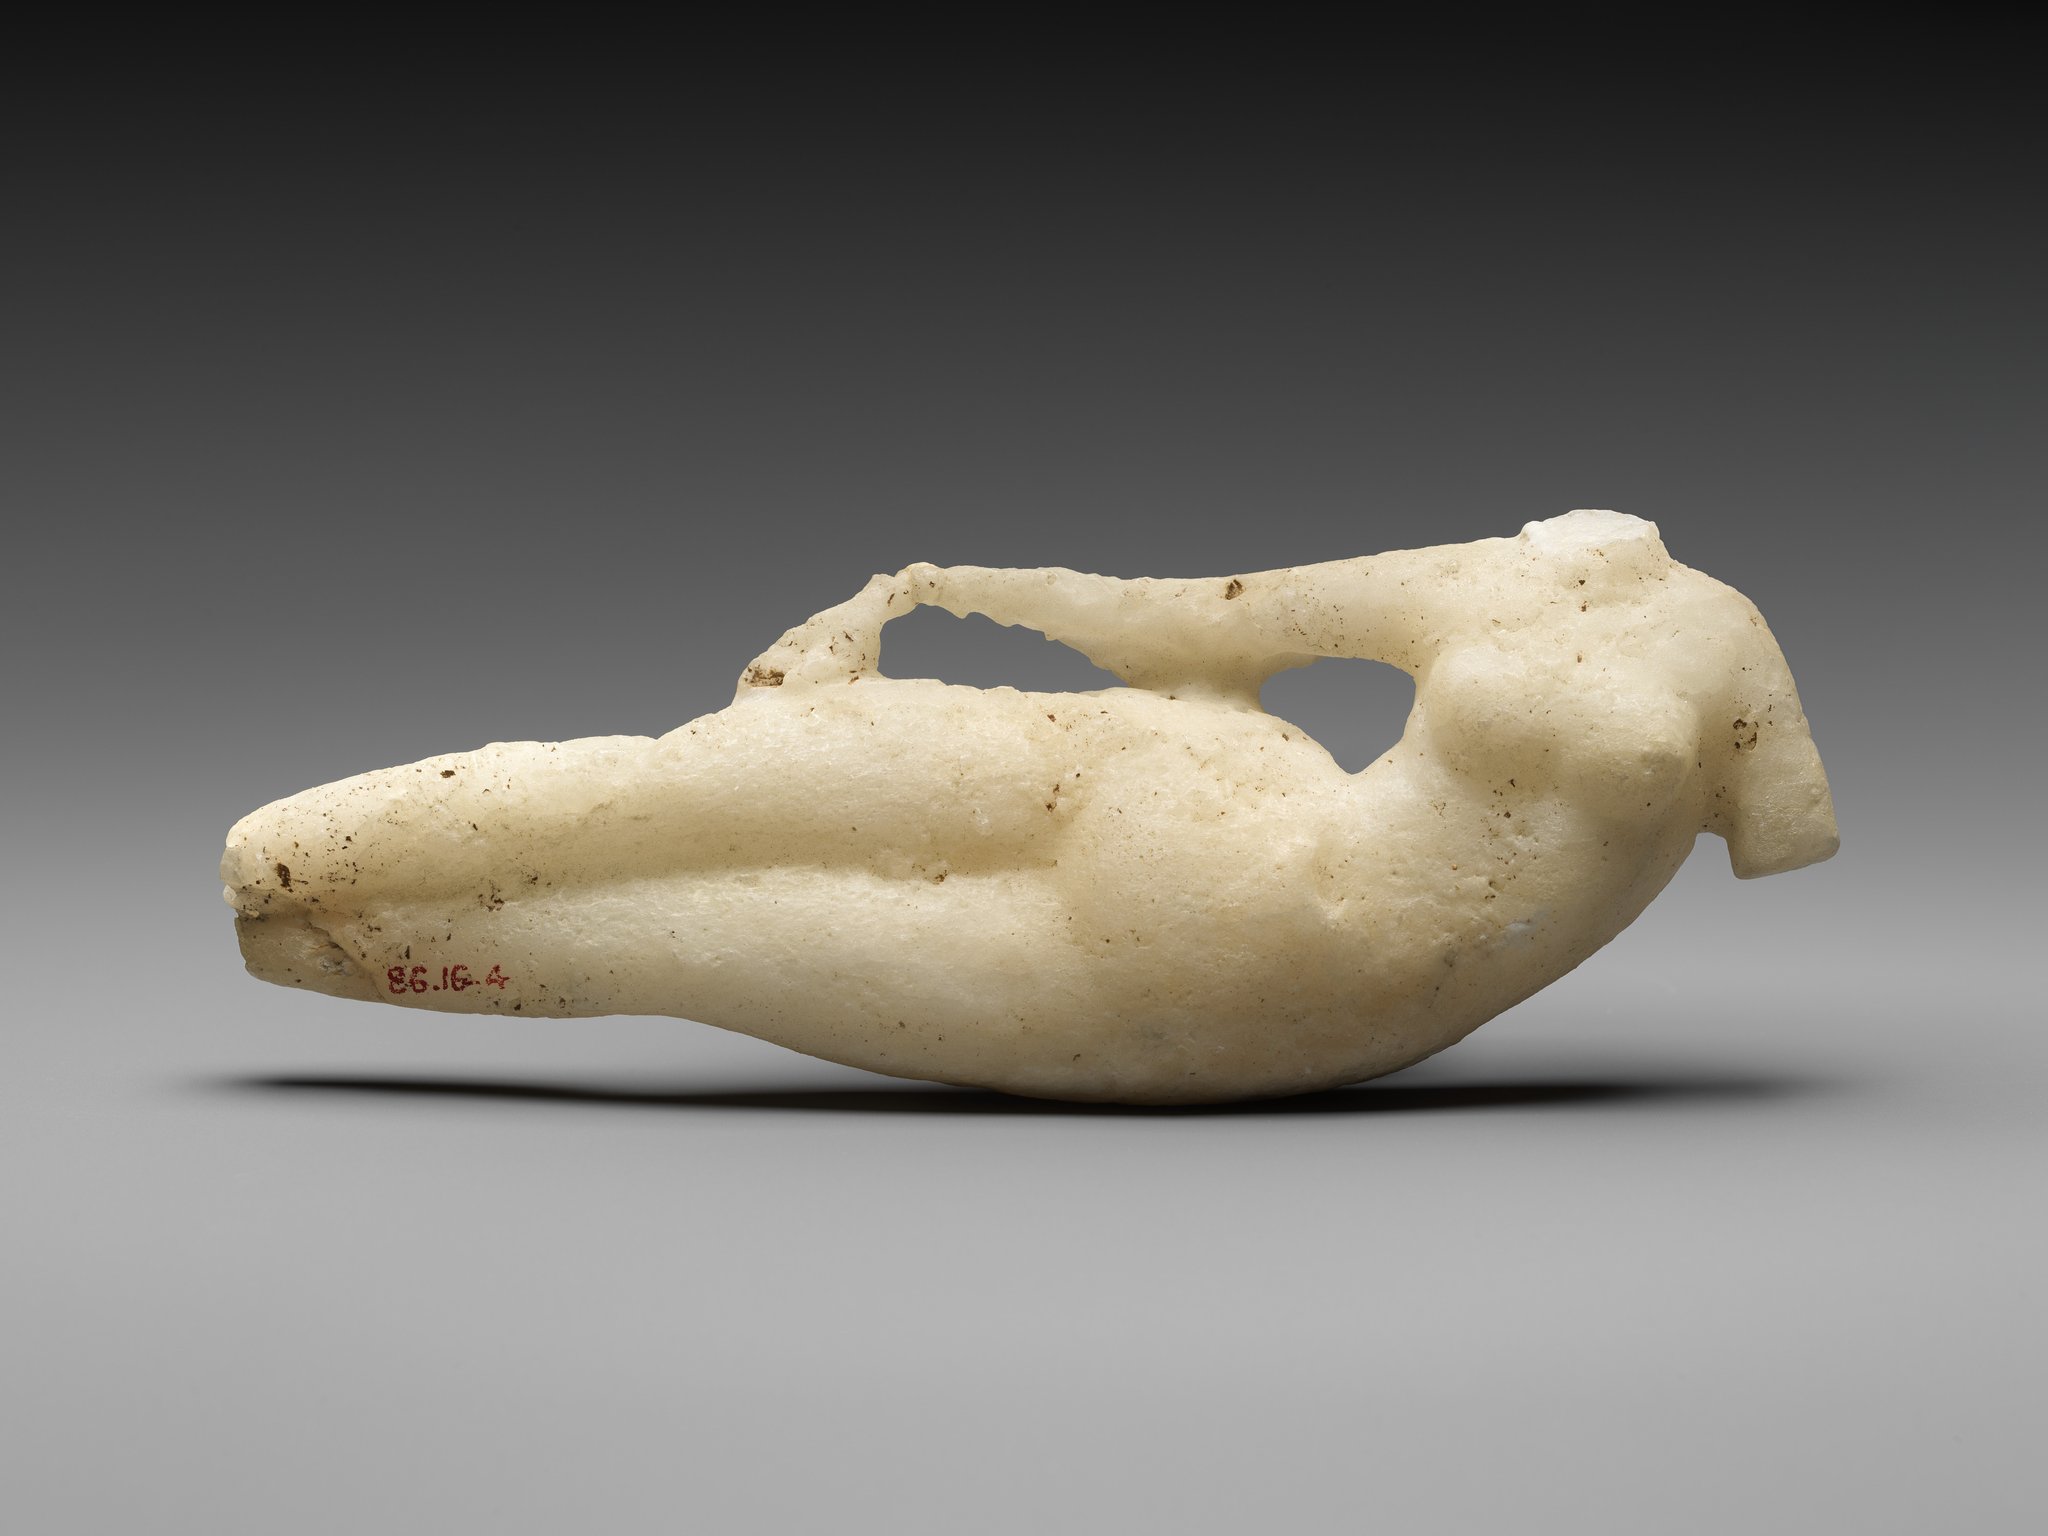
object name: sculpture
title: Figure of reclining woman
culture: parthian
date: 101-200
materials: alabaster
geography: mesopotamia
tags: women